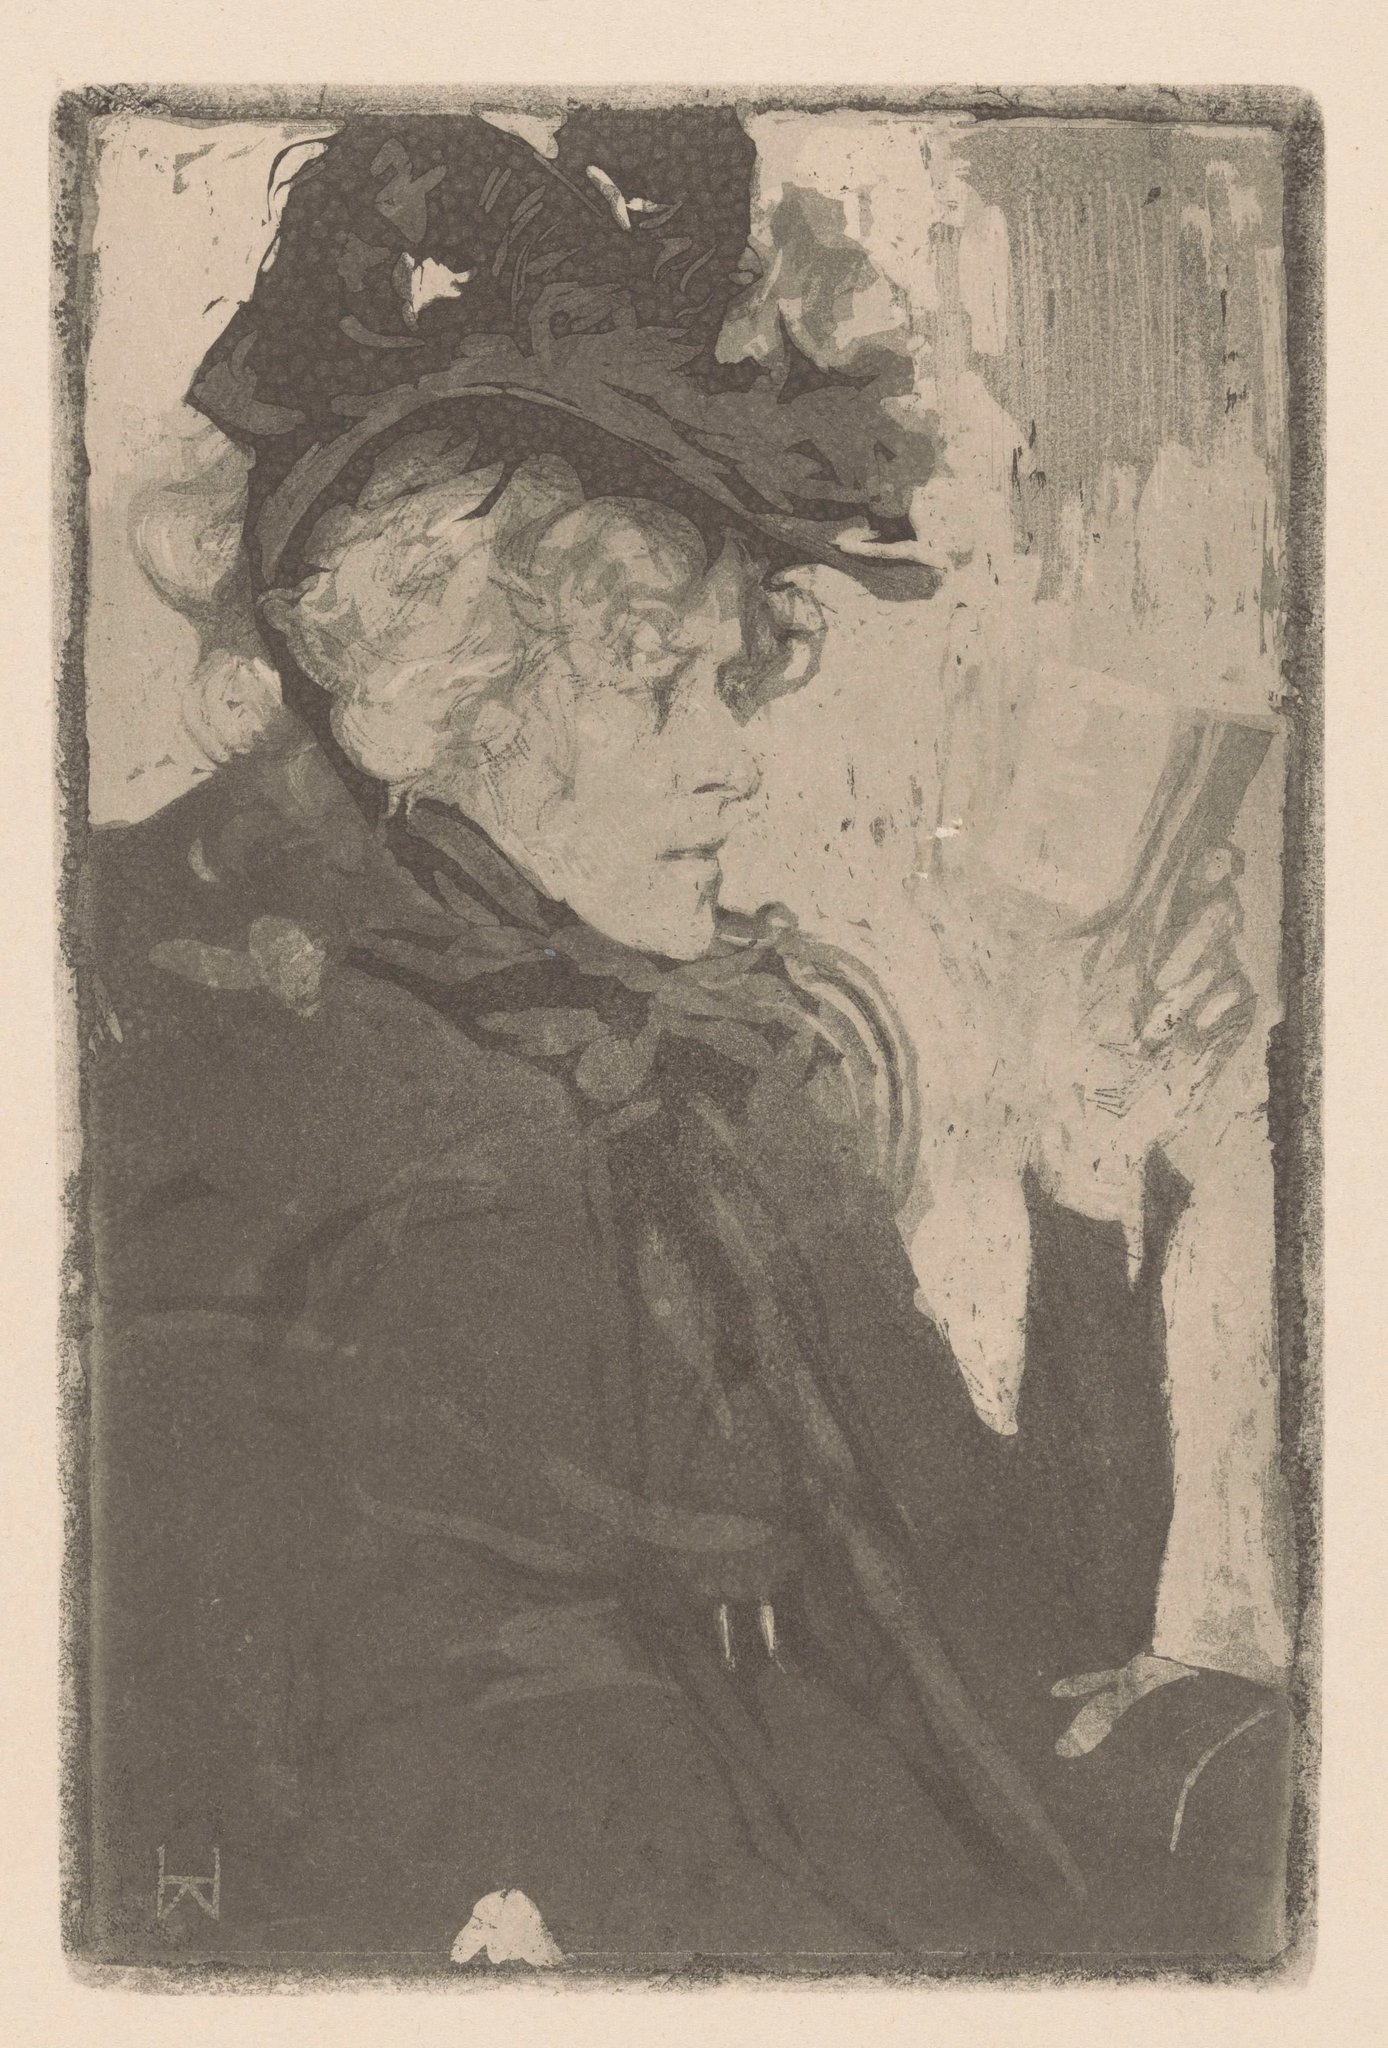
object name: print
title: Lezende vrouw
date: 1902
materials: paper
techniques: aquatint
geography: munich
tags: newspaper, news-sheet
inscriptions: collector's mark: Lugt 2228, collector's mark: Lugt 4780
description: Prent afkomstig uit: Zeitschrift für bildende Kunst N.F. XIII. Leipzig: E.A. Seemann, 1902.